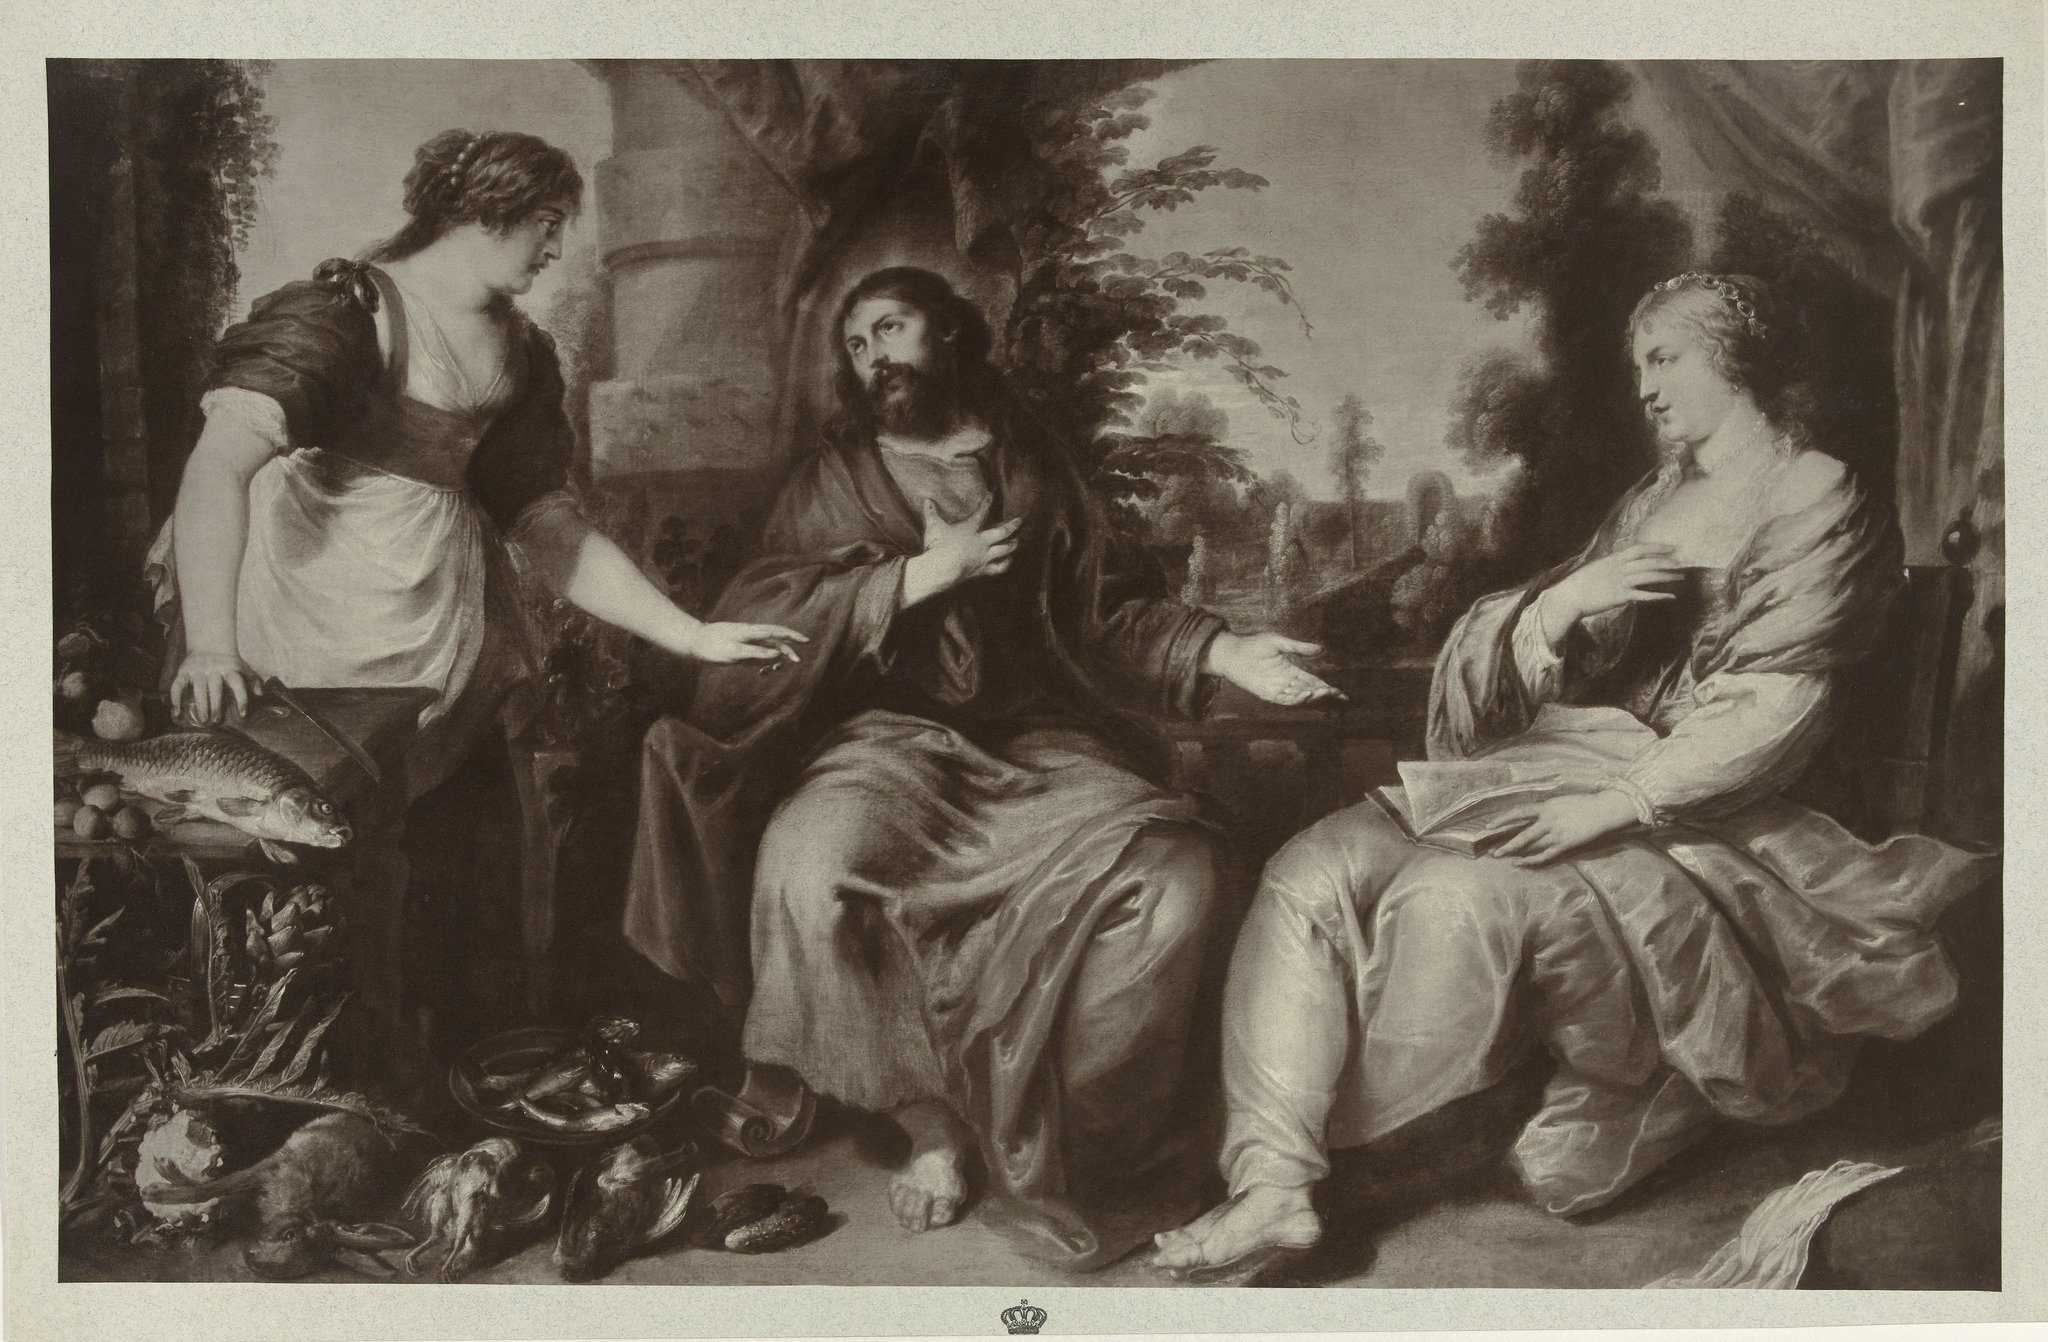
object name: reproduction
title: Vincent Malo, Christus, Martha, Maria, mus. Amsterdam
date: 1866-1900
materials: cardboard, paper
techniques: carbon print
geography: amsterdam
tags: christ in the house of martha and mary (luke 10:38-42)